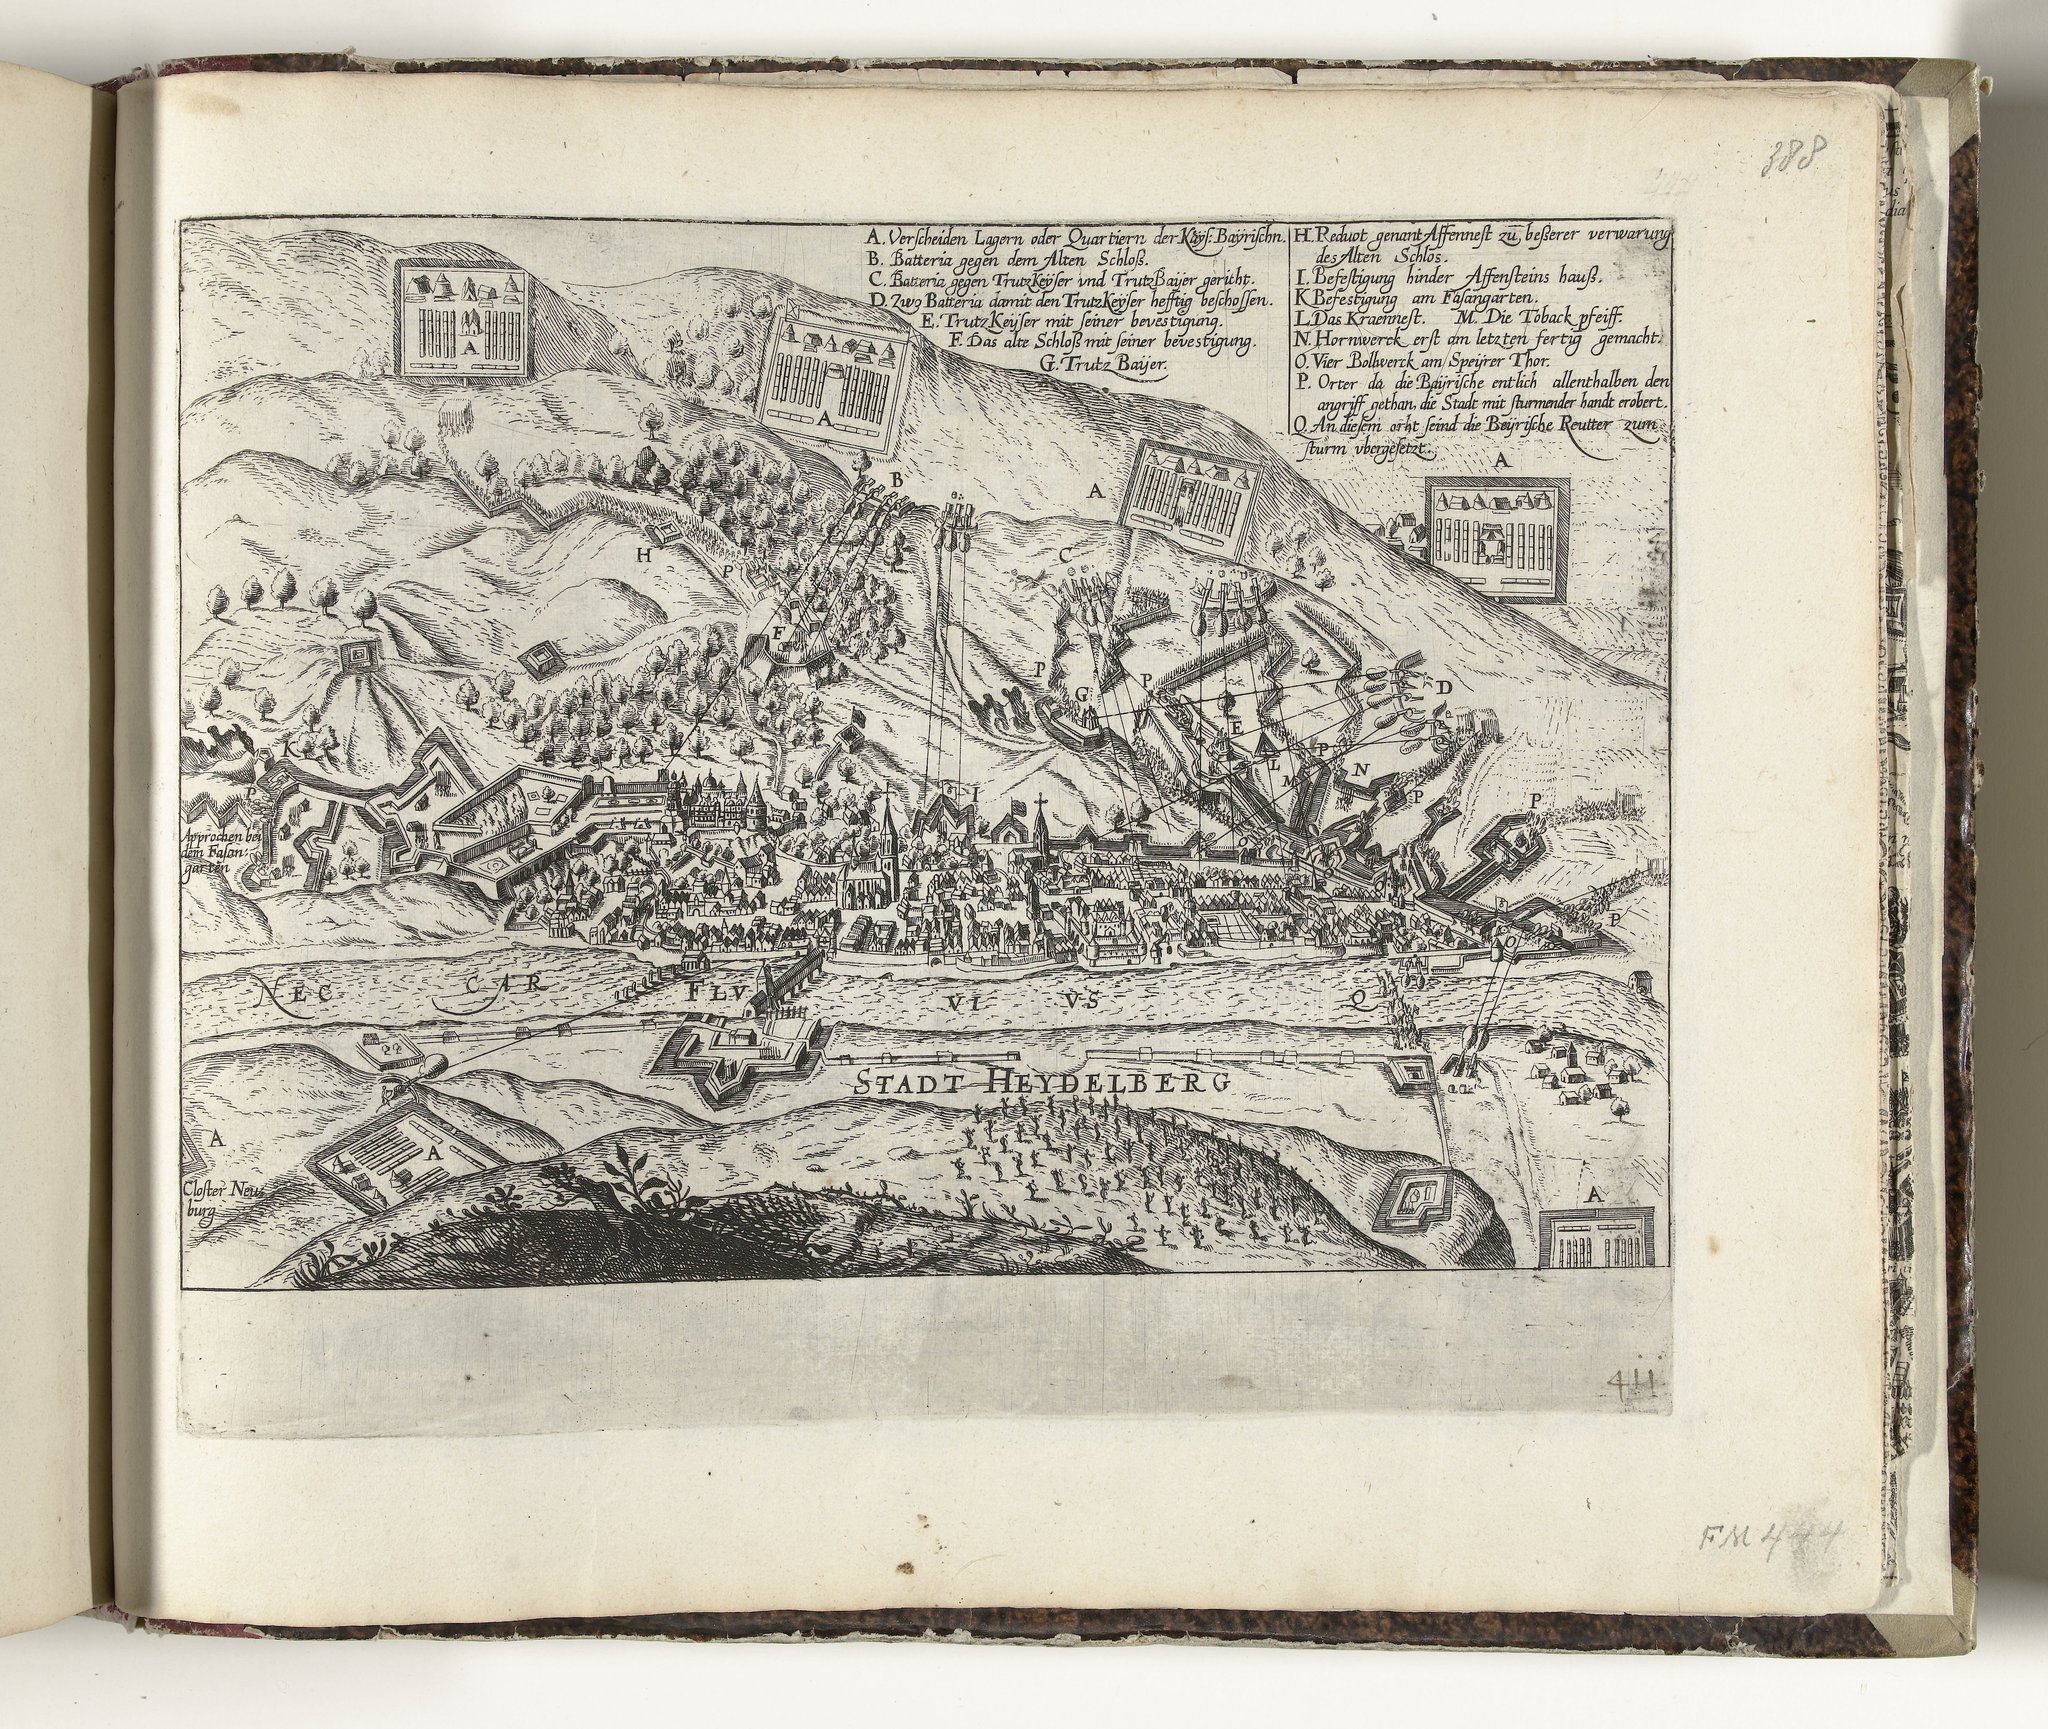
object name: print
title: Serie 11: Varia Buitenlandse Gebeurtenissen, 1571-1631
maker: frans hogenberg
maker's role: print maker, publisher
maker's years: 1538-1590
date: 1622-1624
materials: paper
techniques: etching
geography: cologne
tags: siege, position war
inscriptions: inscription: ‘411’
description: Beleg van Heidelberg door Beierse troepen, van 21 juni tot 6 september 1622. Zonder onderschrift, boven een legenda A-Q in het Duits. Rechtsonder met pen genummerd: 411. De prent maakt deel uit van een album.